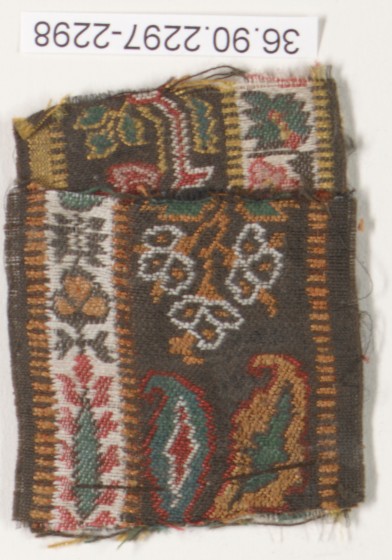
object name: border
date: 1801-1900